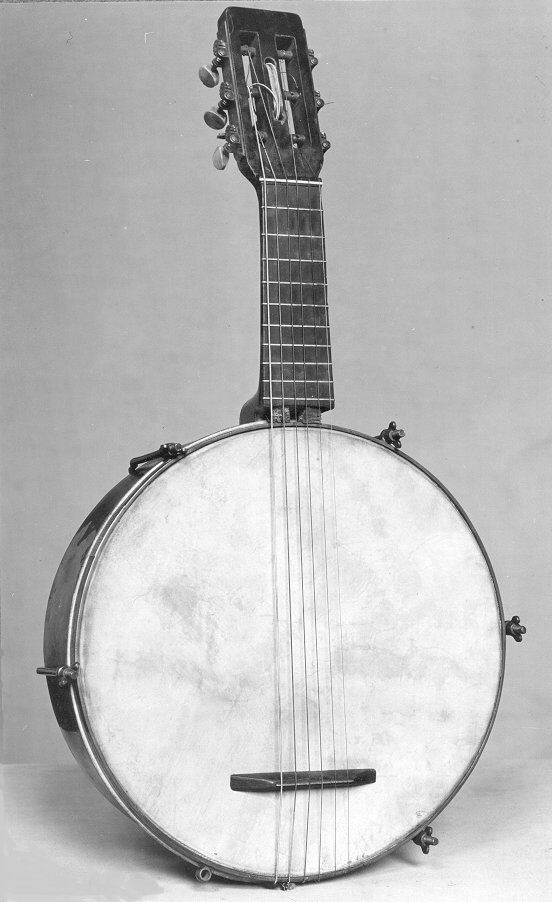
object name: cither banjo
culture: austrian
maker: karl schamal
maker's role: maker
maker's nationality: czech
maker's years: 1849-1919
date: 1801-1900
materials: brass, parchment, metal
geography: austria